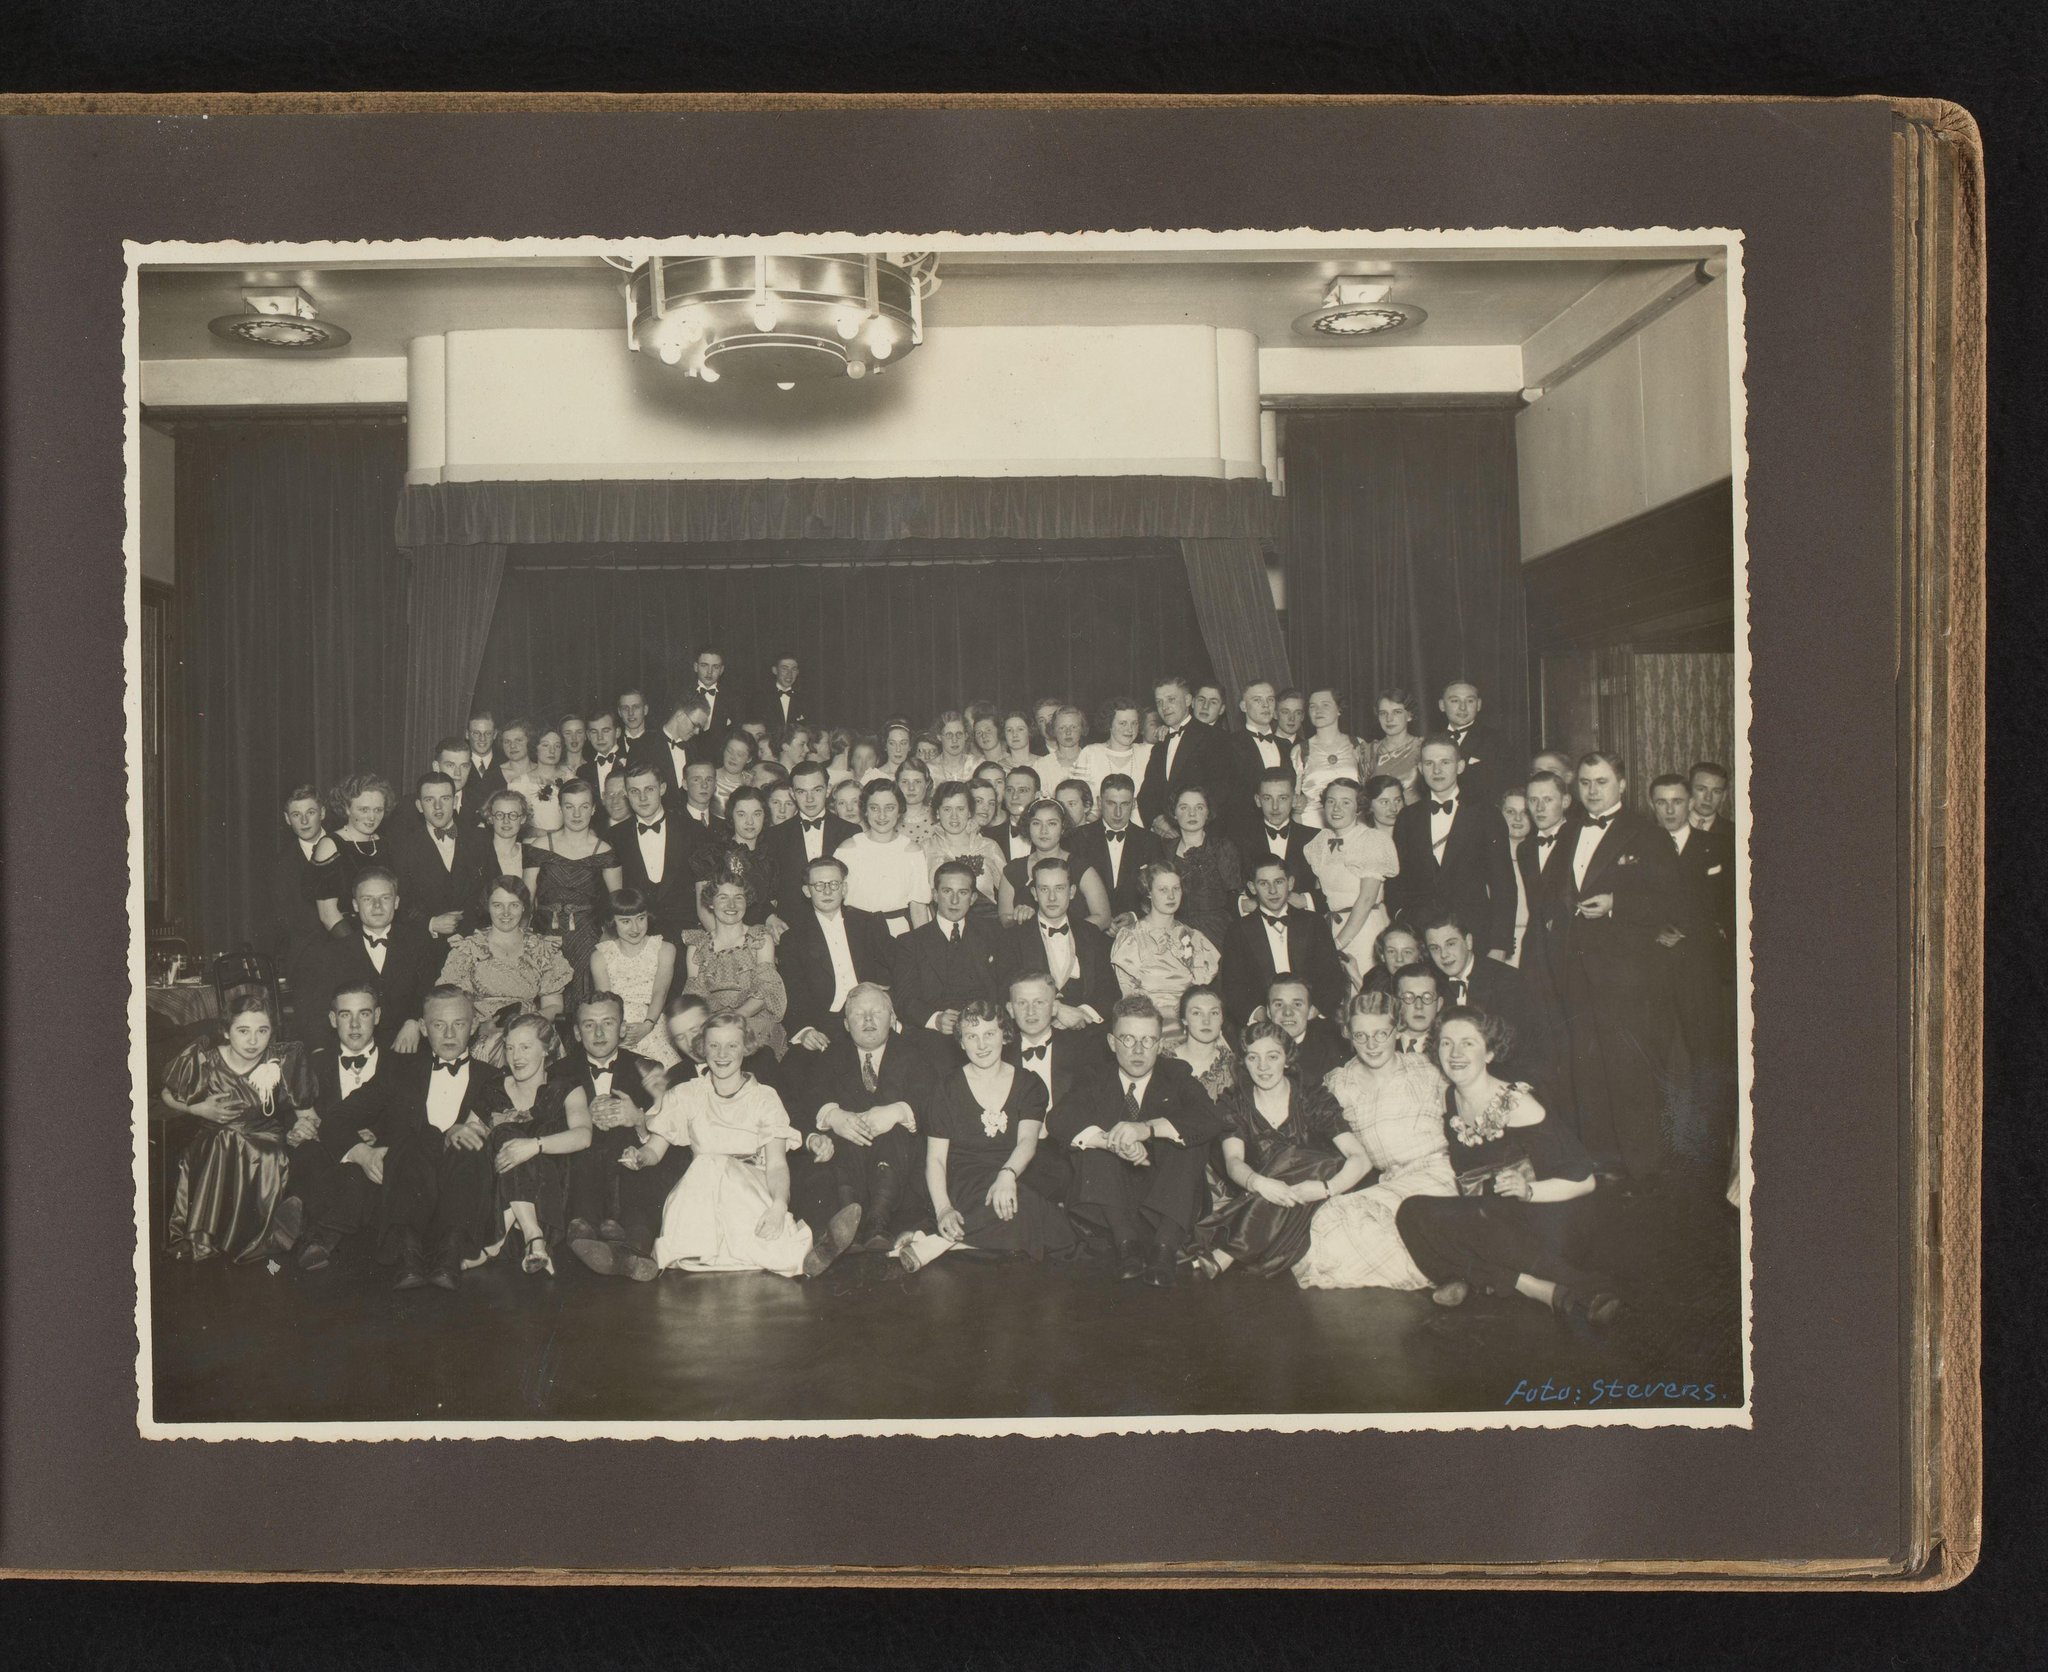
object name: photograph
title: Groepsportret van leerlingen van de MTS te Haarlem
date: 1936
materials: paper, photographic support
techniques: gelatin silver print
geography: haarlem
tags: students' organization, vocational education, e.g.: junior technical school, haarlem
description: Albumblad met een groepsfoto van alle leerlingen van het jaar 1935-1936 van de MTS te Haarlem, op het toneel na de opvoering van het toneelstuk 'Wat Jonas overkwam' op 22 februari 1936. Onderdeel van het fotoalbum 'Jaarfeesten van het Corps M.T.S. te Haarlem'.